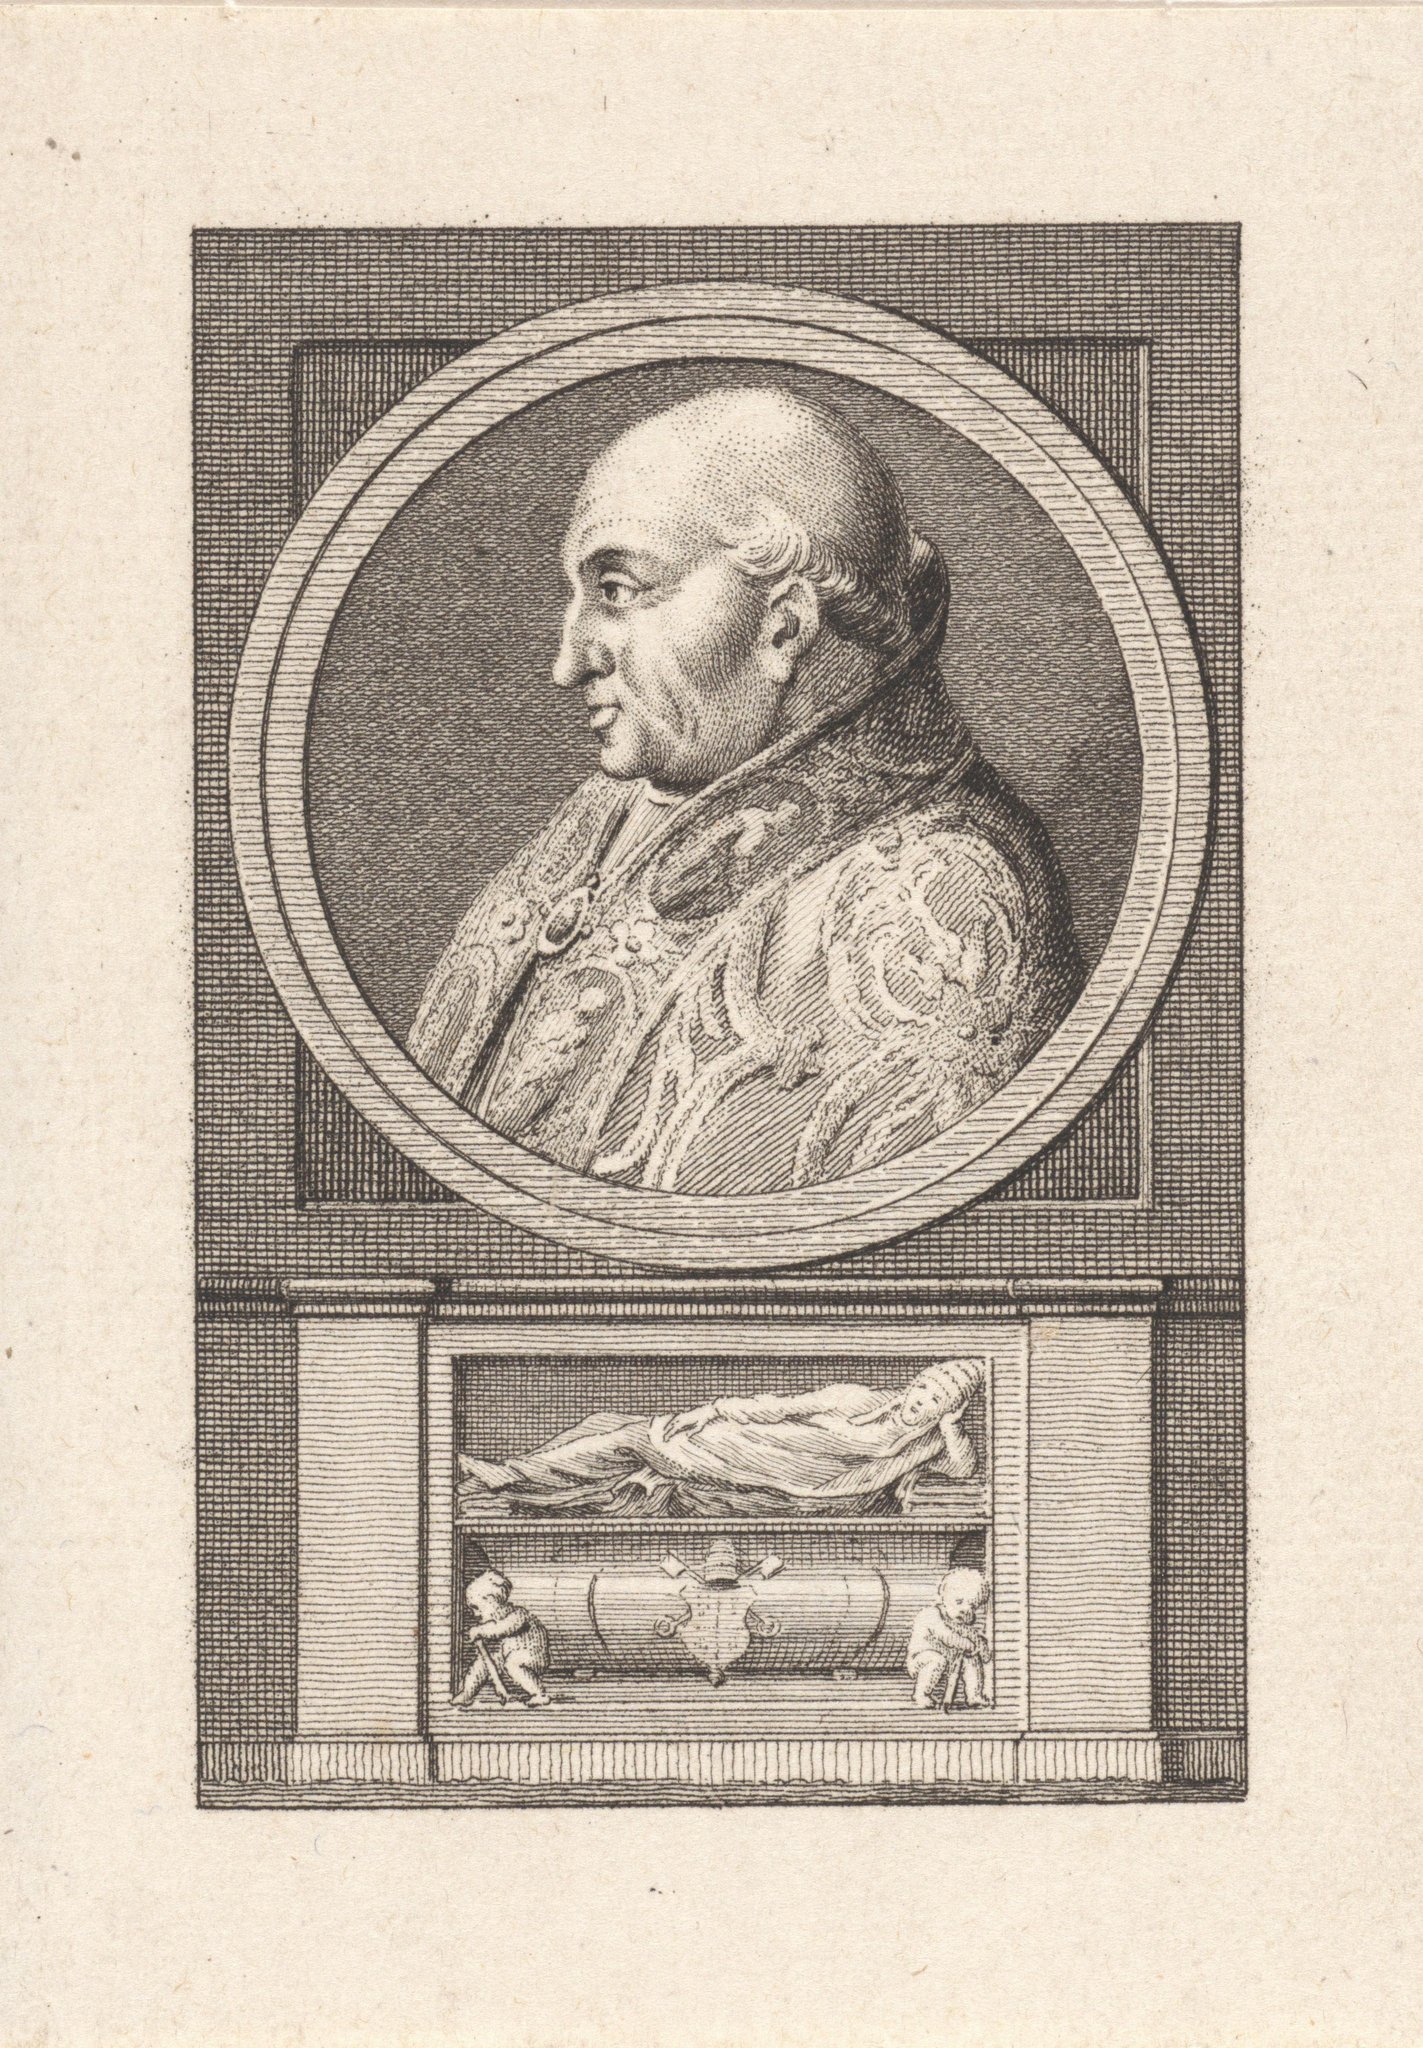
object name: print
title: Portret van paus Adrianus VI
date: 1783-1795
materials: paper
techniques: etching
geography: amsterdam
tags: utrecht, clergyman, grave, tomb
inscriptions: collector's mark: Lugt 2228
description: Latere staat prent gebruikt in: Fokke, Jan. Geschiedenissen der Vereenigde Nederlanden voor de vaderlandsche jeugd Ie-XXVste deel. Amsterdam: Johannes Allart, 1783-1795. Deel III.